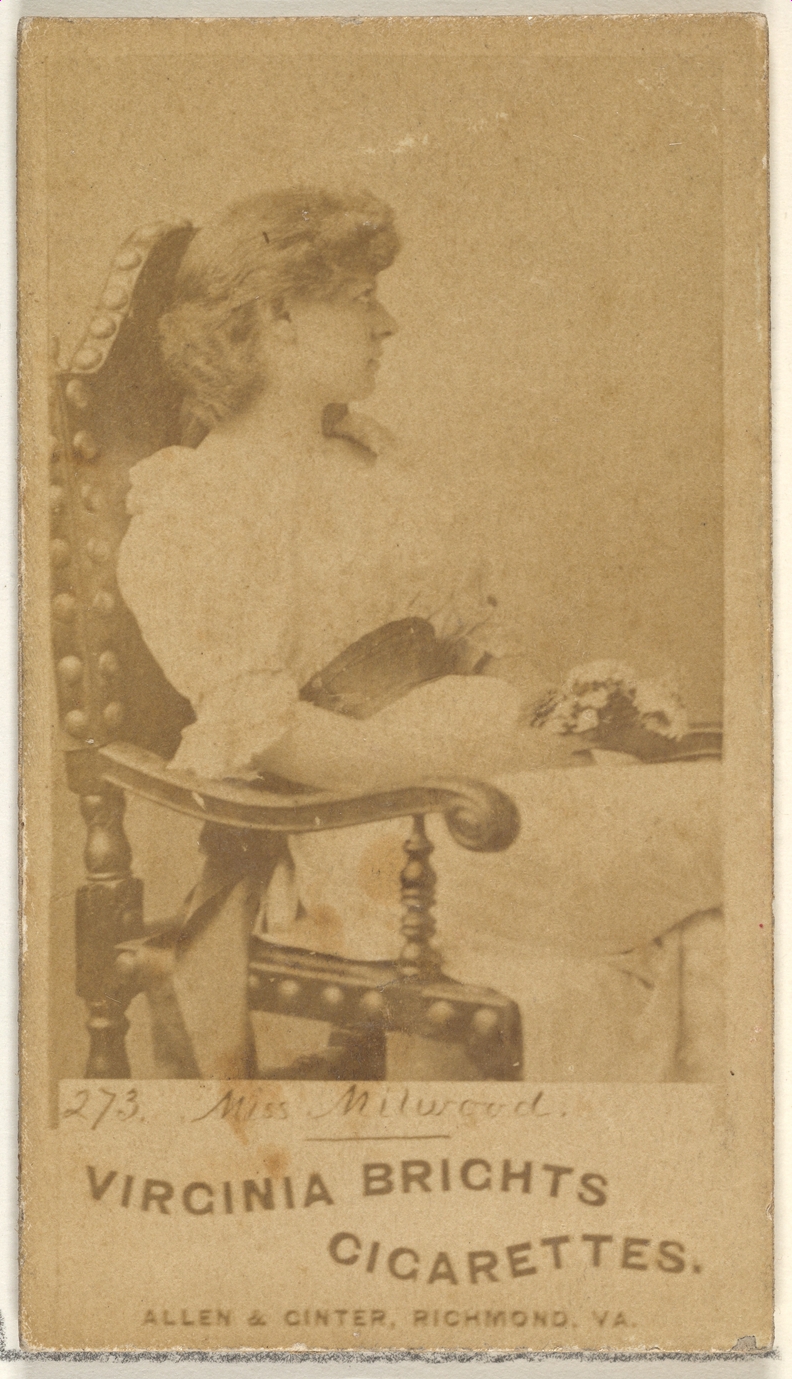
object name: photograph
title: Card 273, Miss Milwood, from the Actors and Actresses series (N45, Type 1) for Virginia Brights Cigarettes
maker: allen & ginter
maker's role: publisher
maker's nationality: american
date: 1888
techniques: albumen silver print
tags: portraits,women,actresses